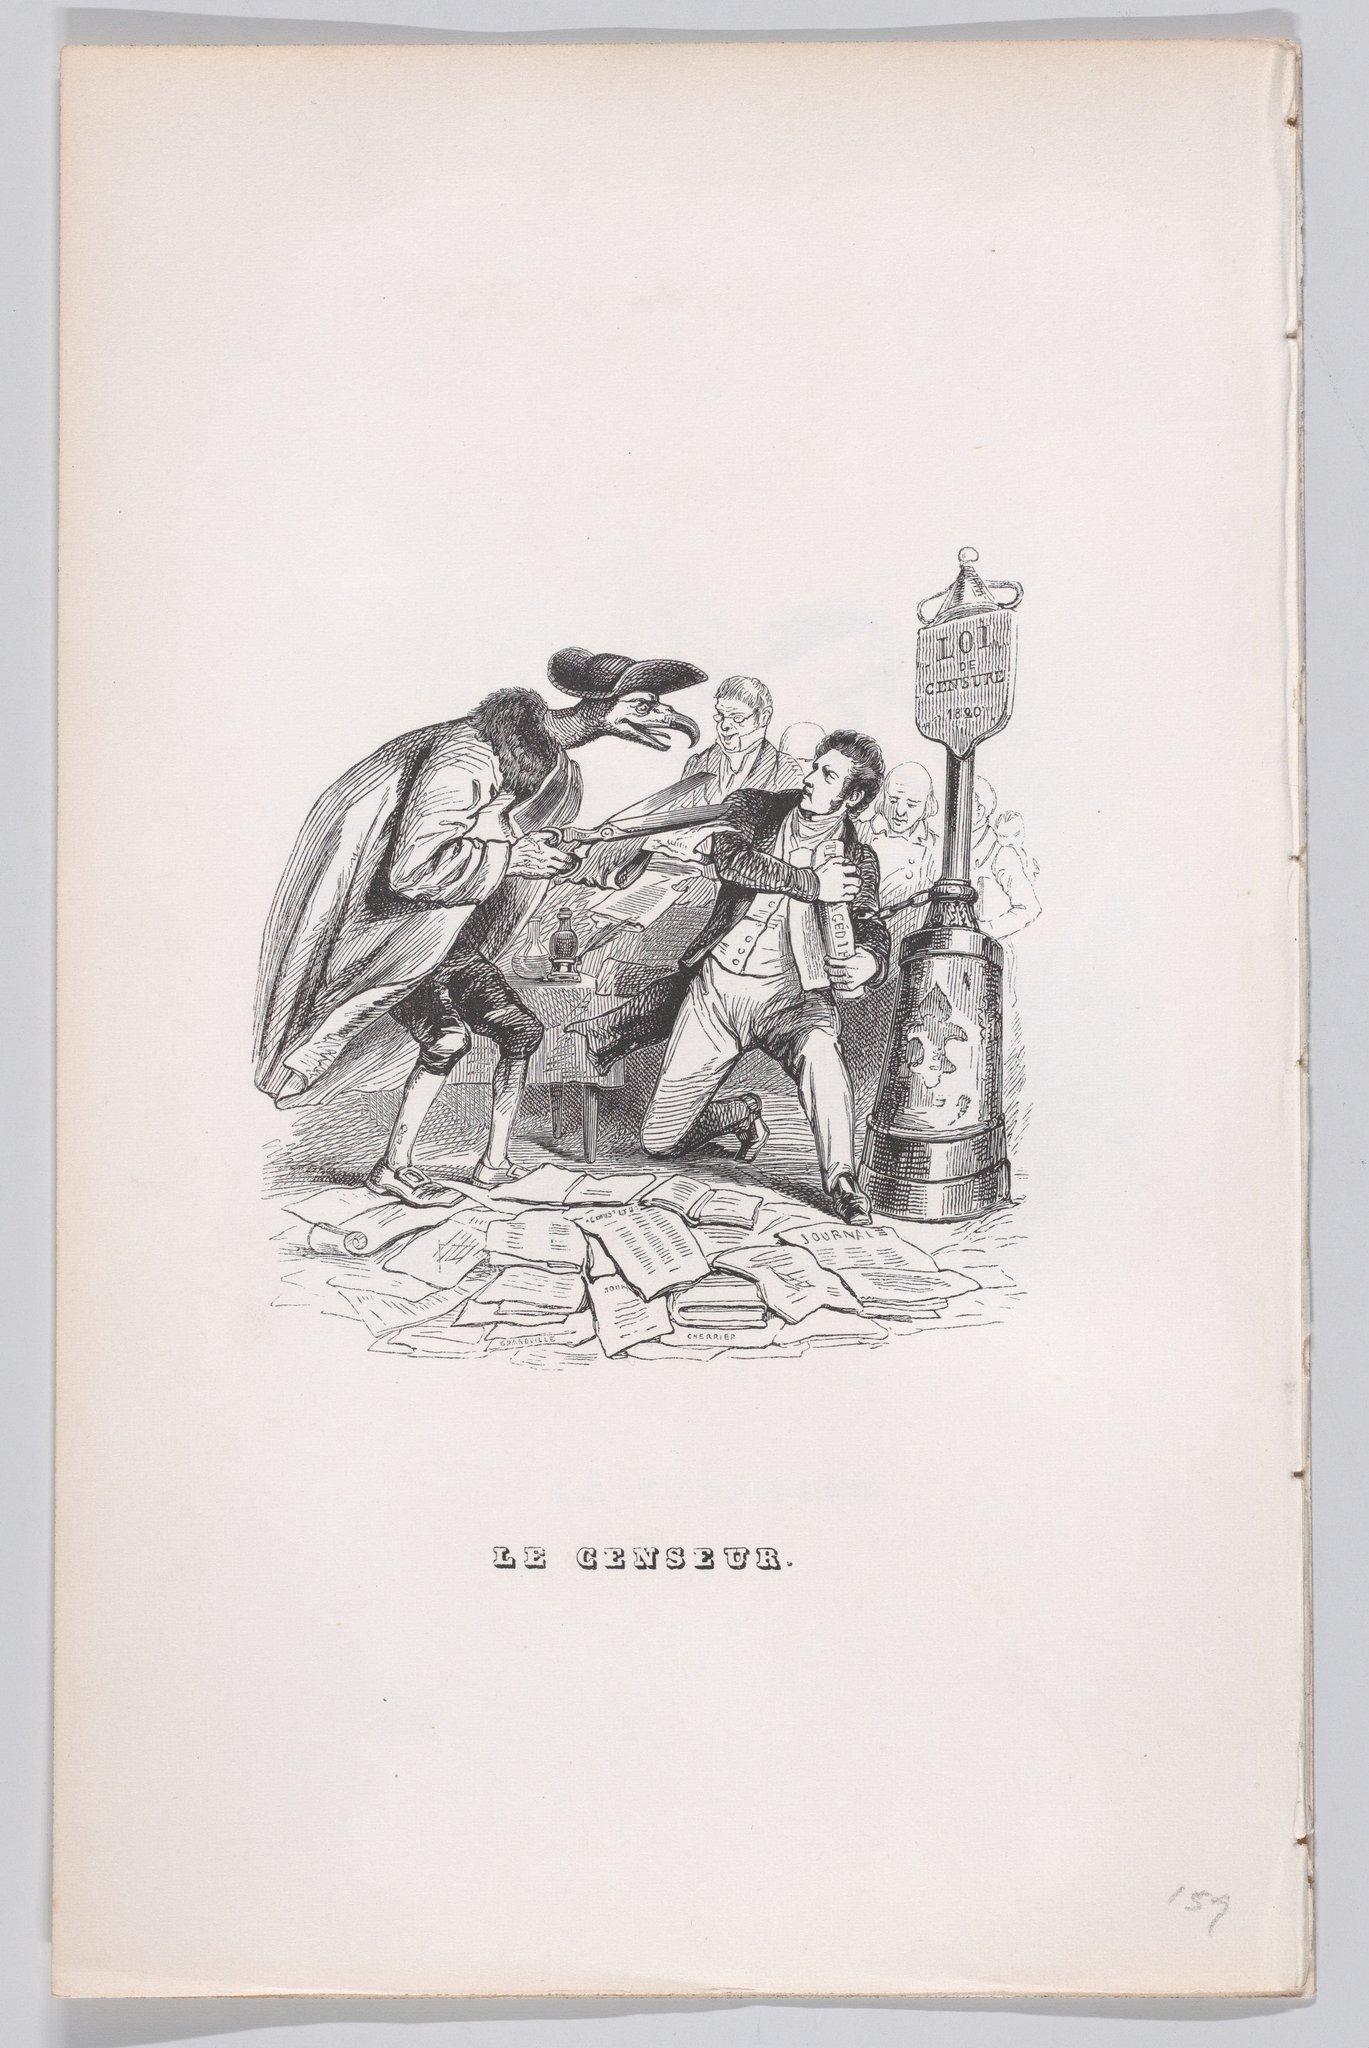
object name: print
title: The Censor, from "The Complete Works of Béranger"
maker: j. j. grandville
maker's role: illustrator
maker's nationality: french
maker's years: 1803-1847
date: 1836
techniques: engraving